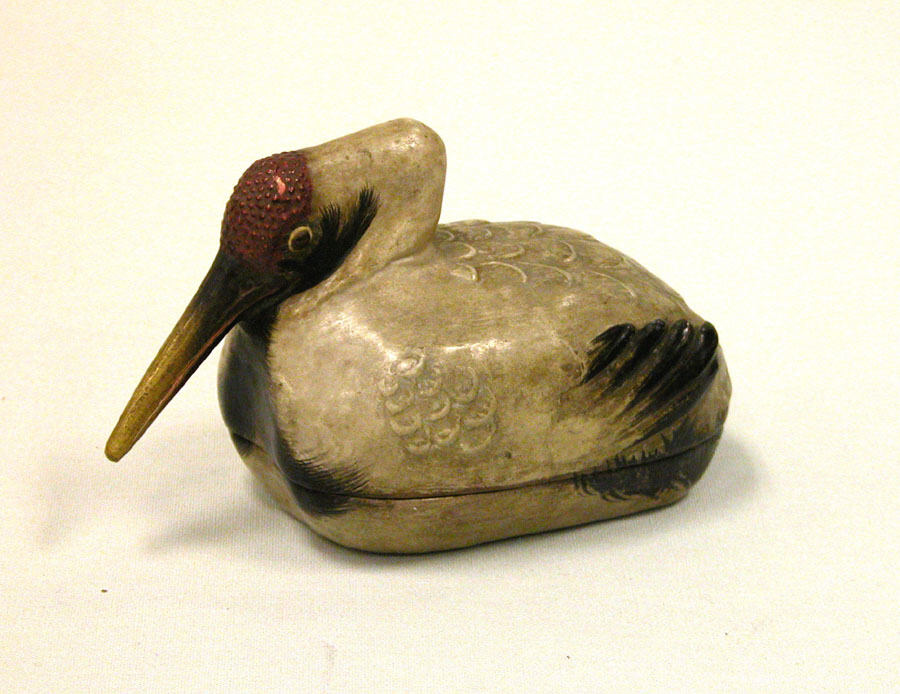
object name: box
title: Box in the shape of young crane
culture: japanese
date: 1801-1900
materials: lacquer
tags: cranes